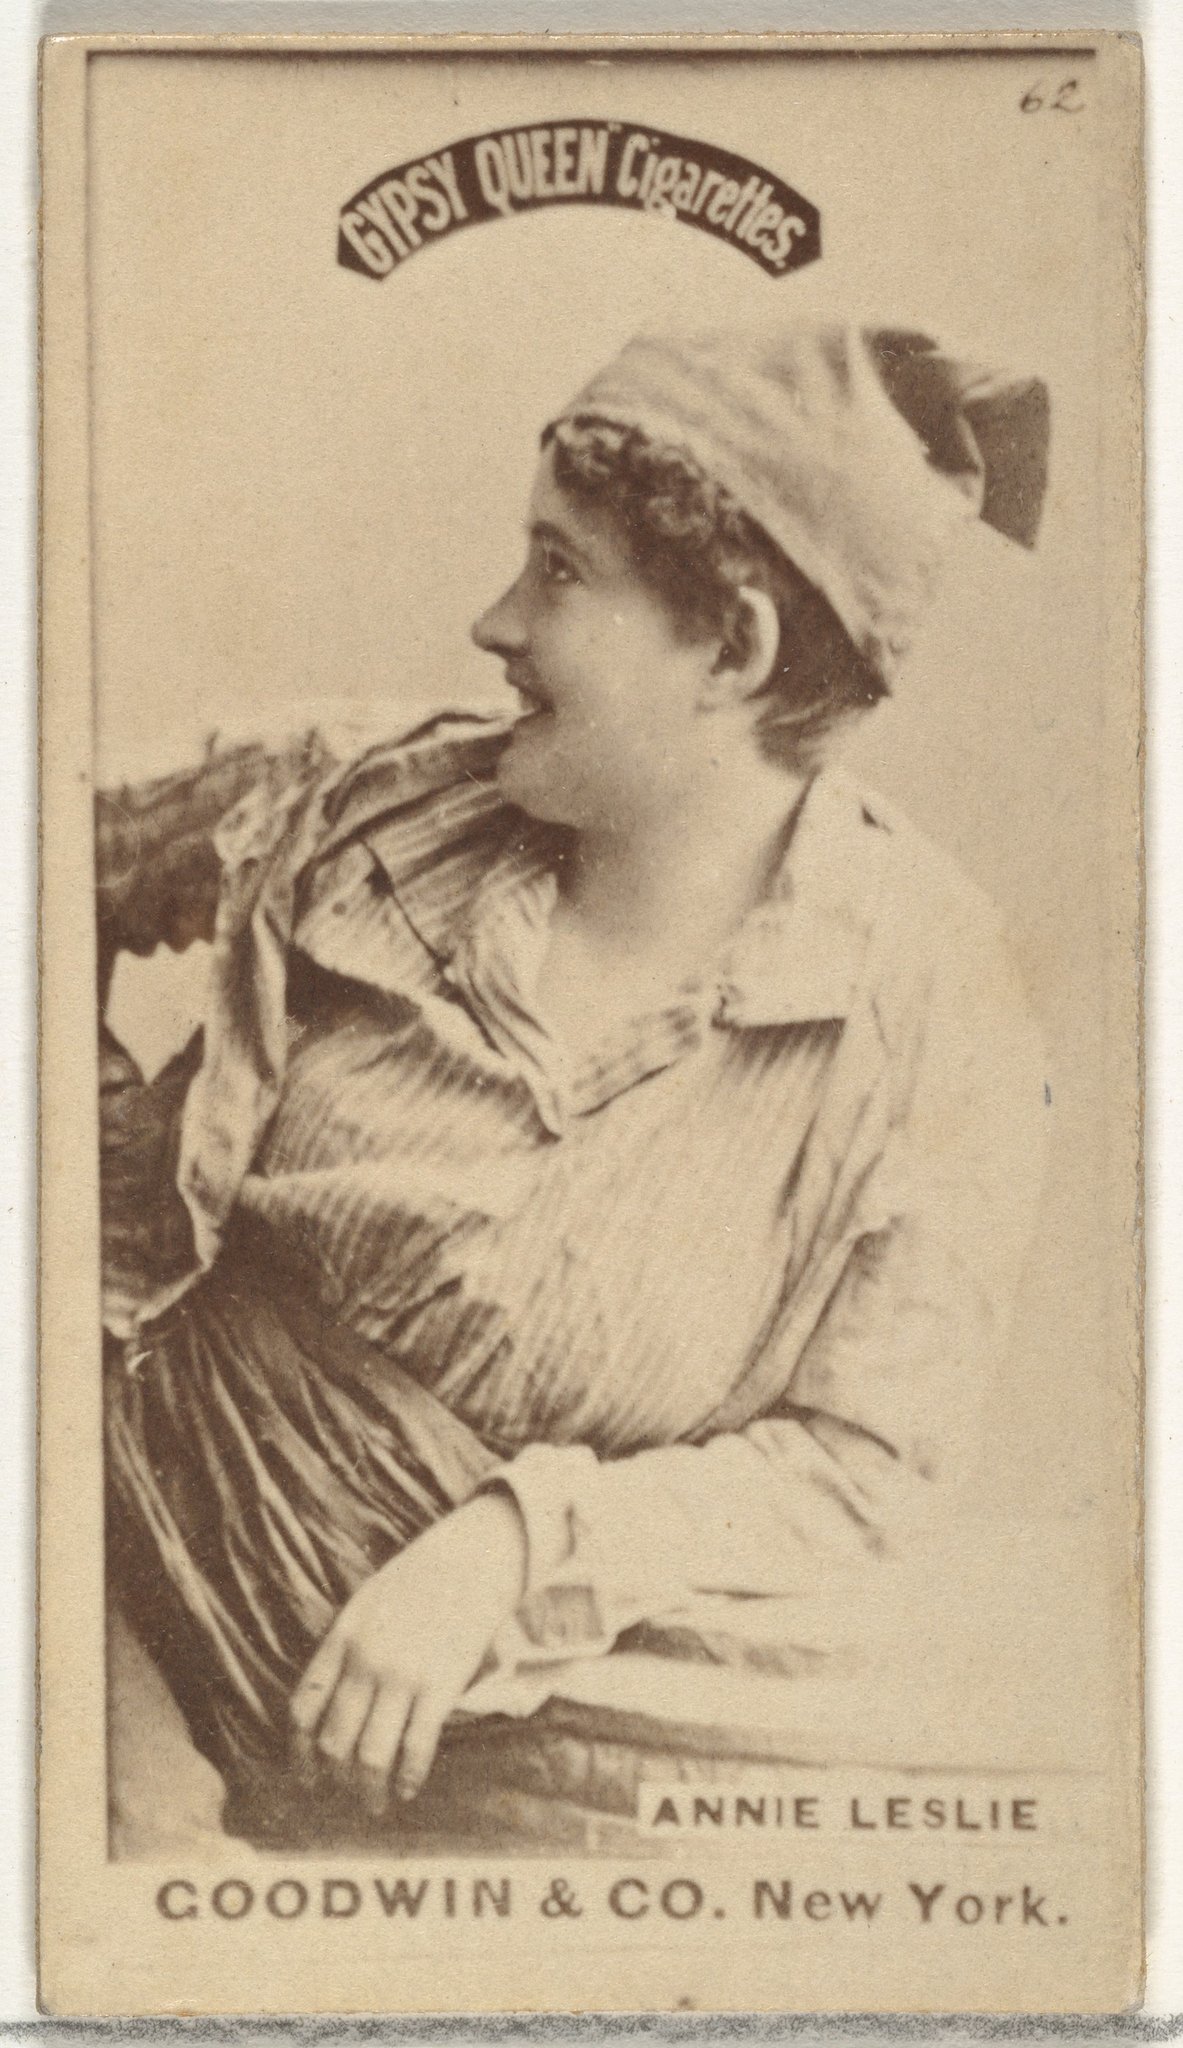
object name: photograph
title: Annie Leslie, from the Actors and Actresses series (N171) for Gypsy Queen Cigarettes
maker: goodwin & company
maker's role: publisher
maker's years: 1850-1950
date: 1886-1890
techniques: albumen silver print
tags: women,actresses